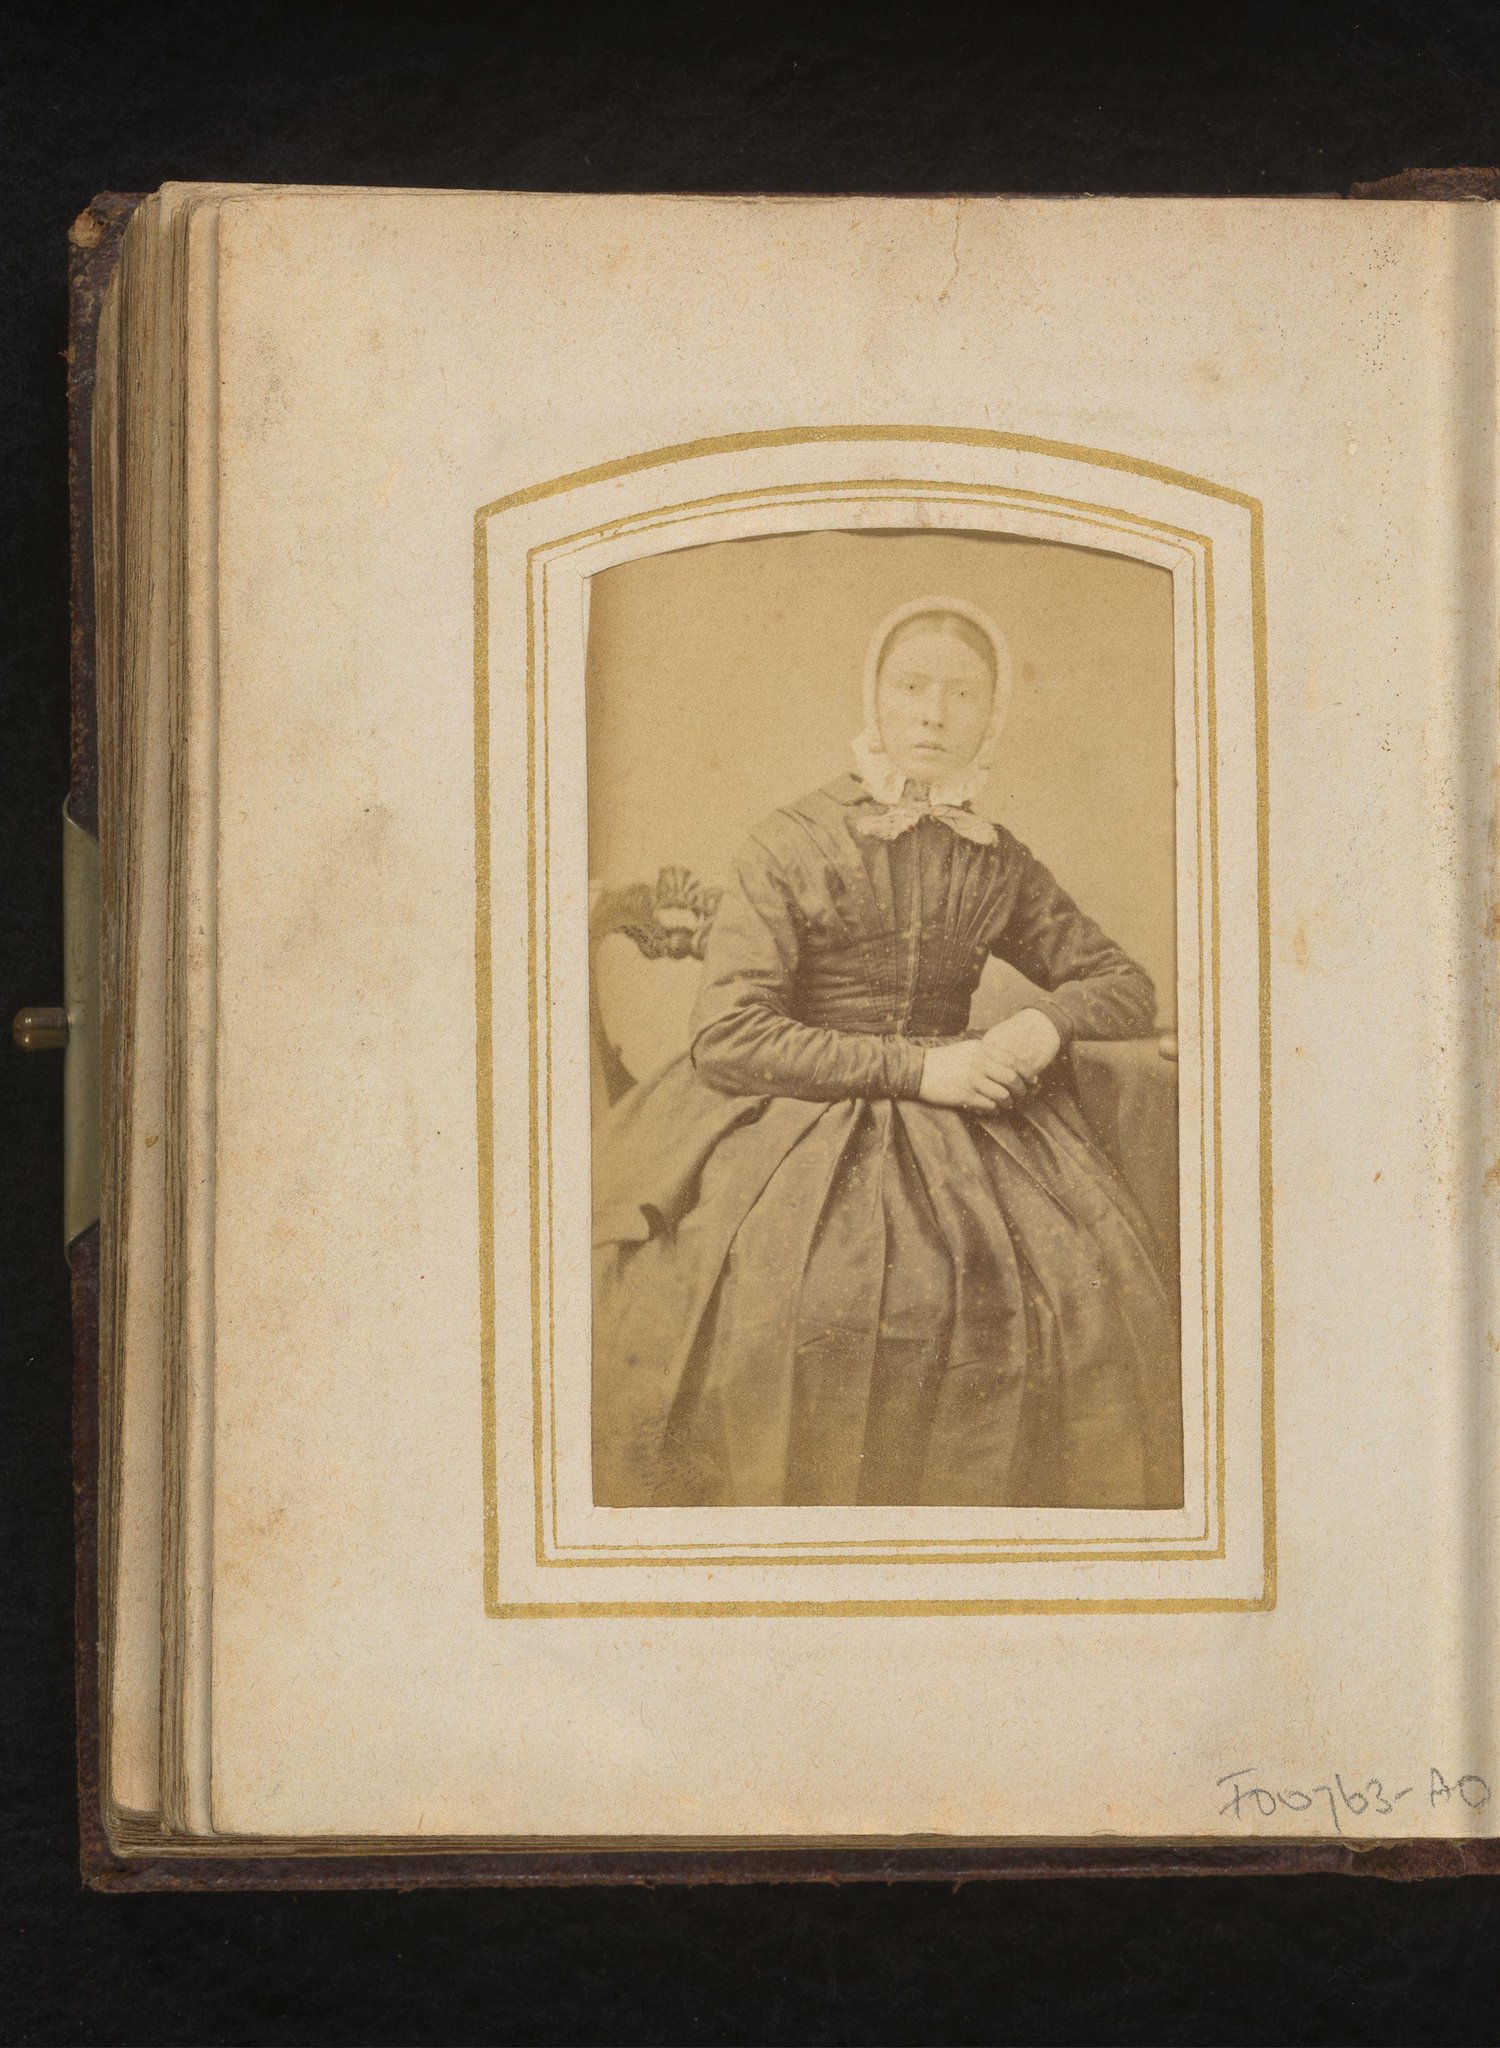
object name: carte de visite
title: Portret van een zittende vrouw met witte muts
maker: mozes cohen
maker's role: fotograaf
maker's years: 1821-1899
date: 1860-1899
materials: cardboard, photographic support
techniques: albumen print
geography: zwolle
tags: sitting figure - aa - female human figure, historical persons - bb - woman, head-gear: cap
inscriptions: inscription: ‘M. Cohen/ Photographe/ DIEZERSTRAAT/ ZWOLLE/ Van deze Photographie/ kunnen steeds nabesteld worden.’